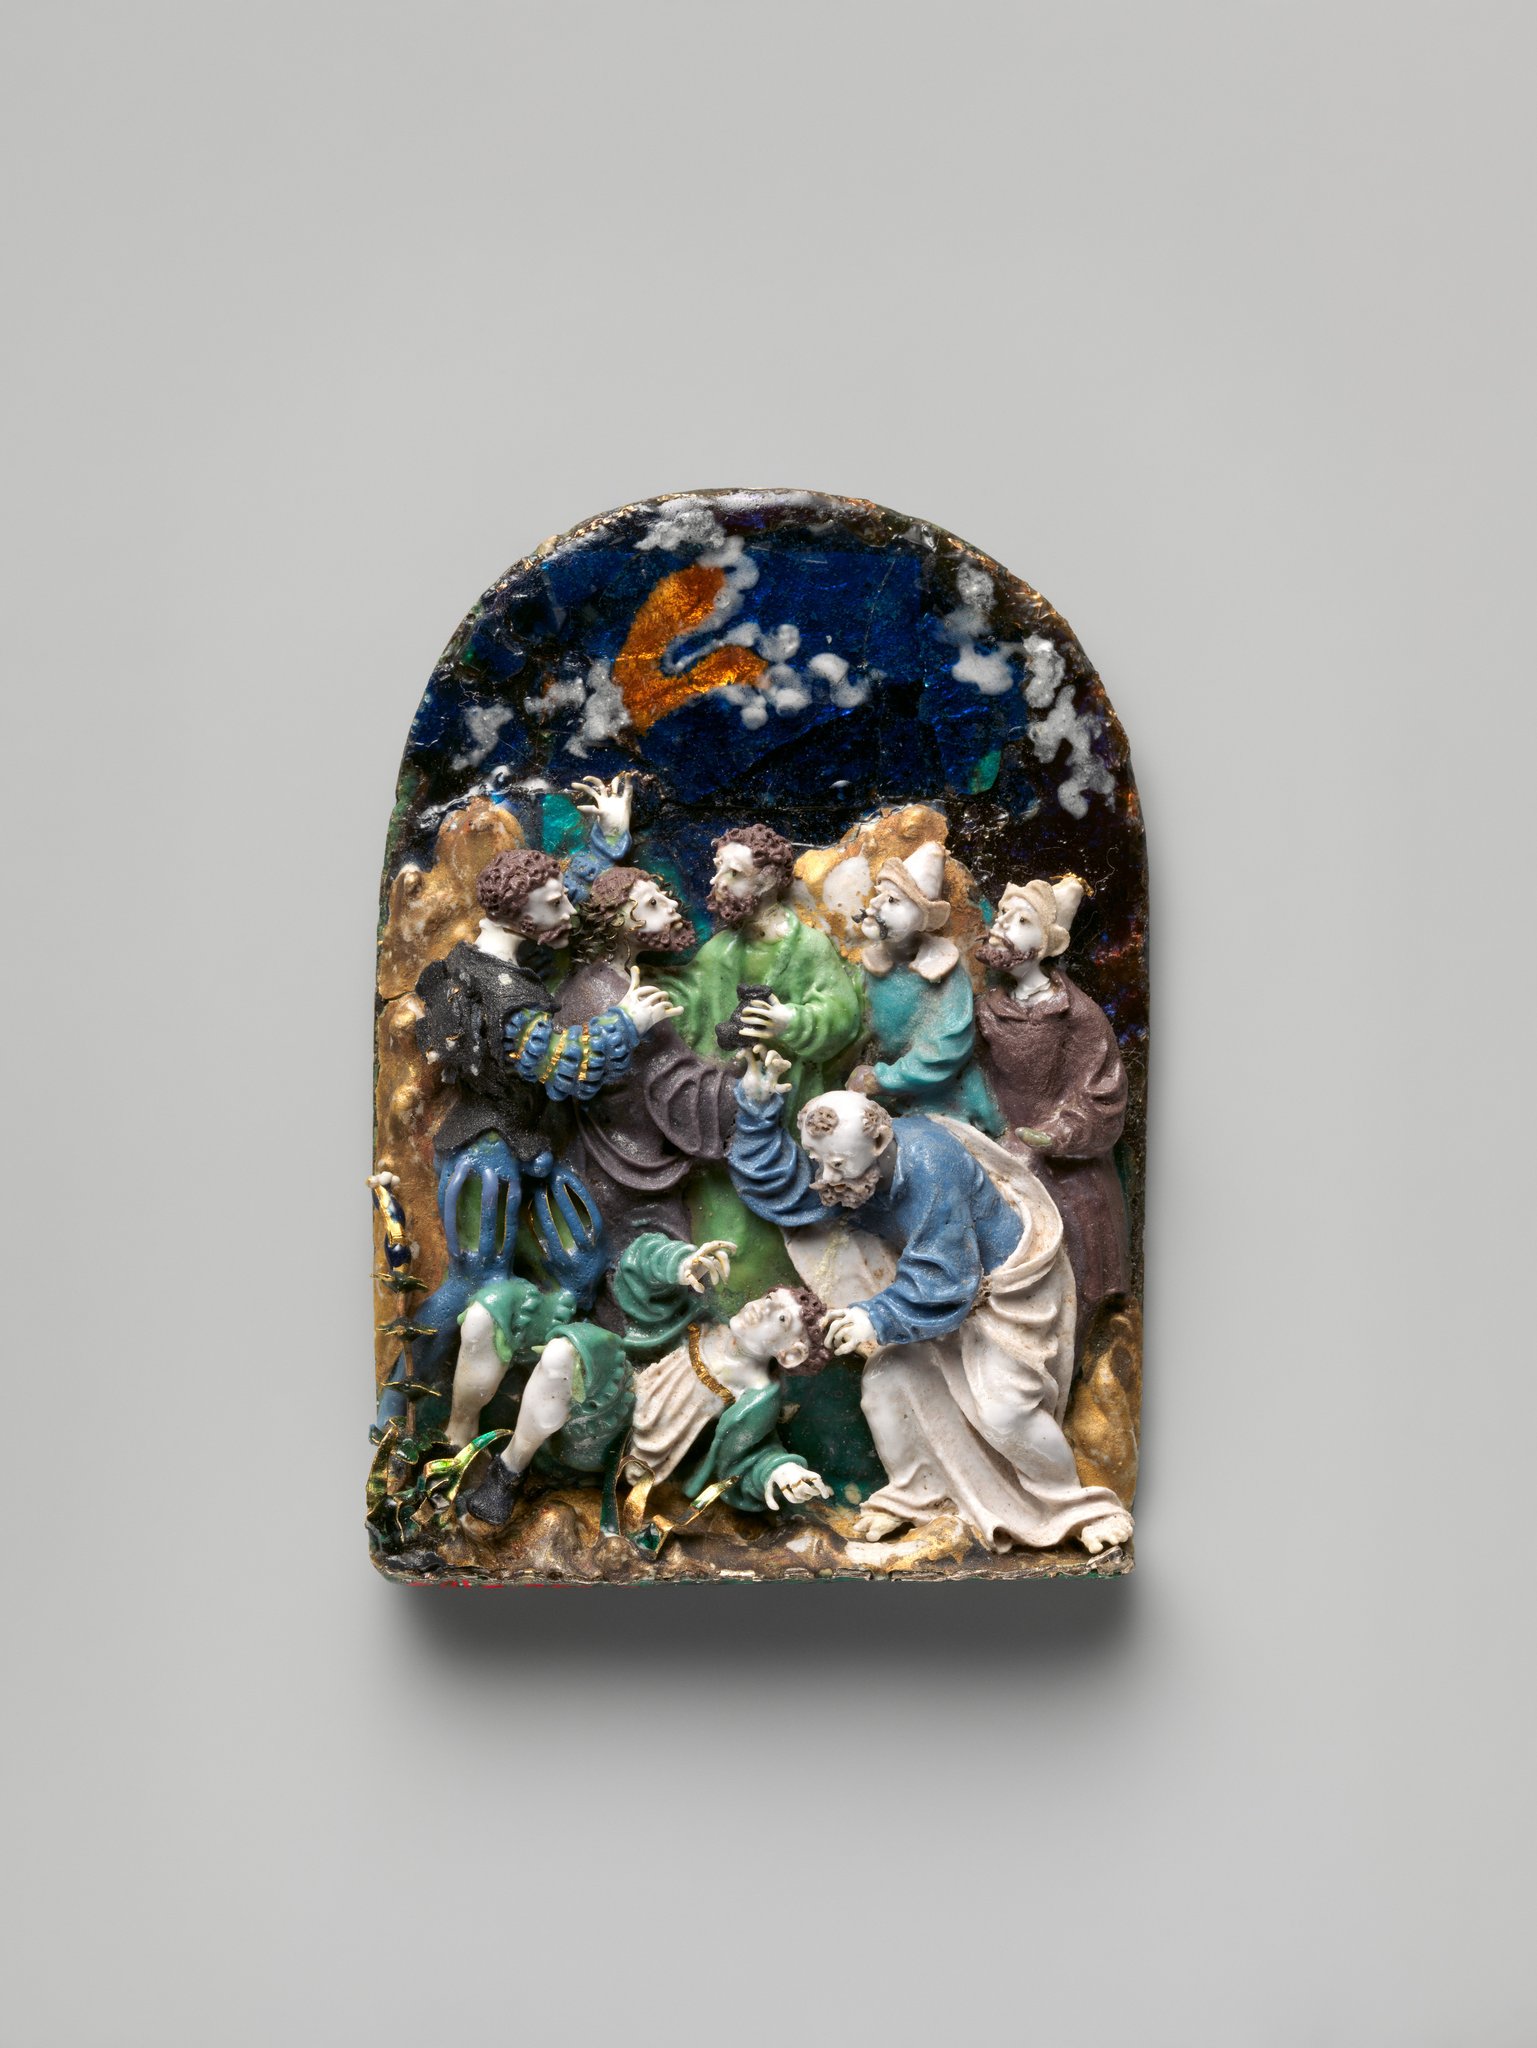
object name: plaquette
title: Capture of Christ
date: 1520-1530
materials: enamel, glass, gold, silver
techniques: lampwork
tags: men,christ